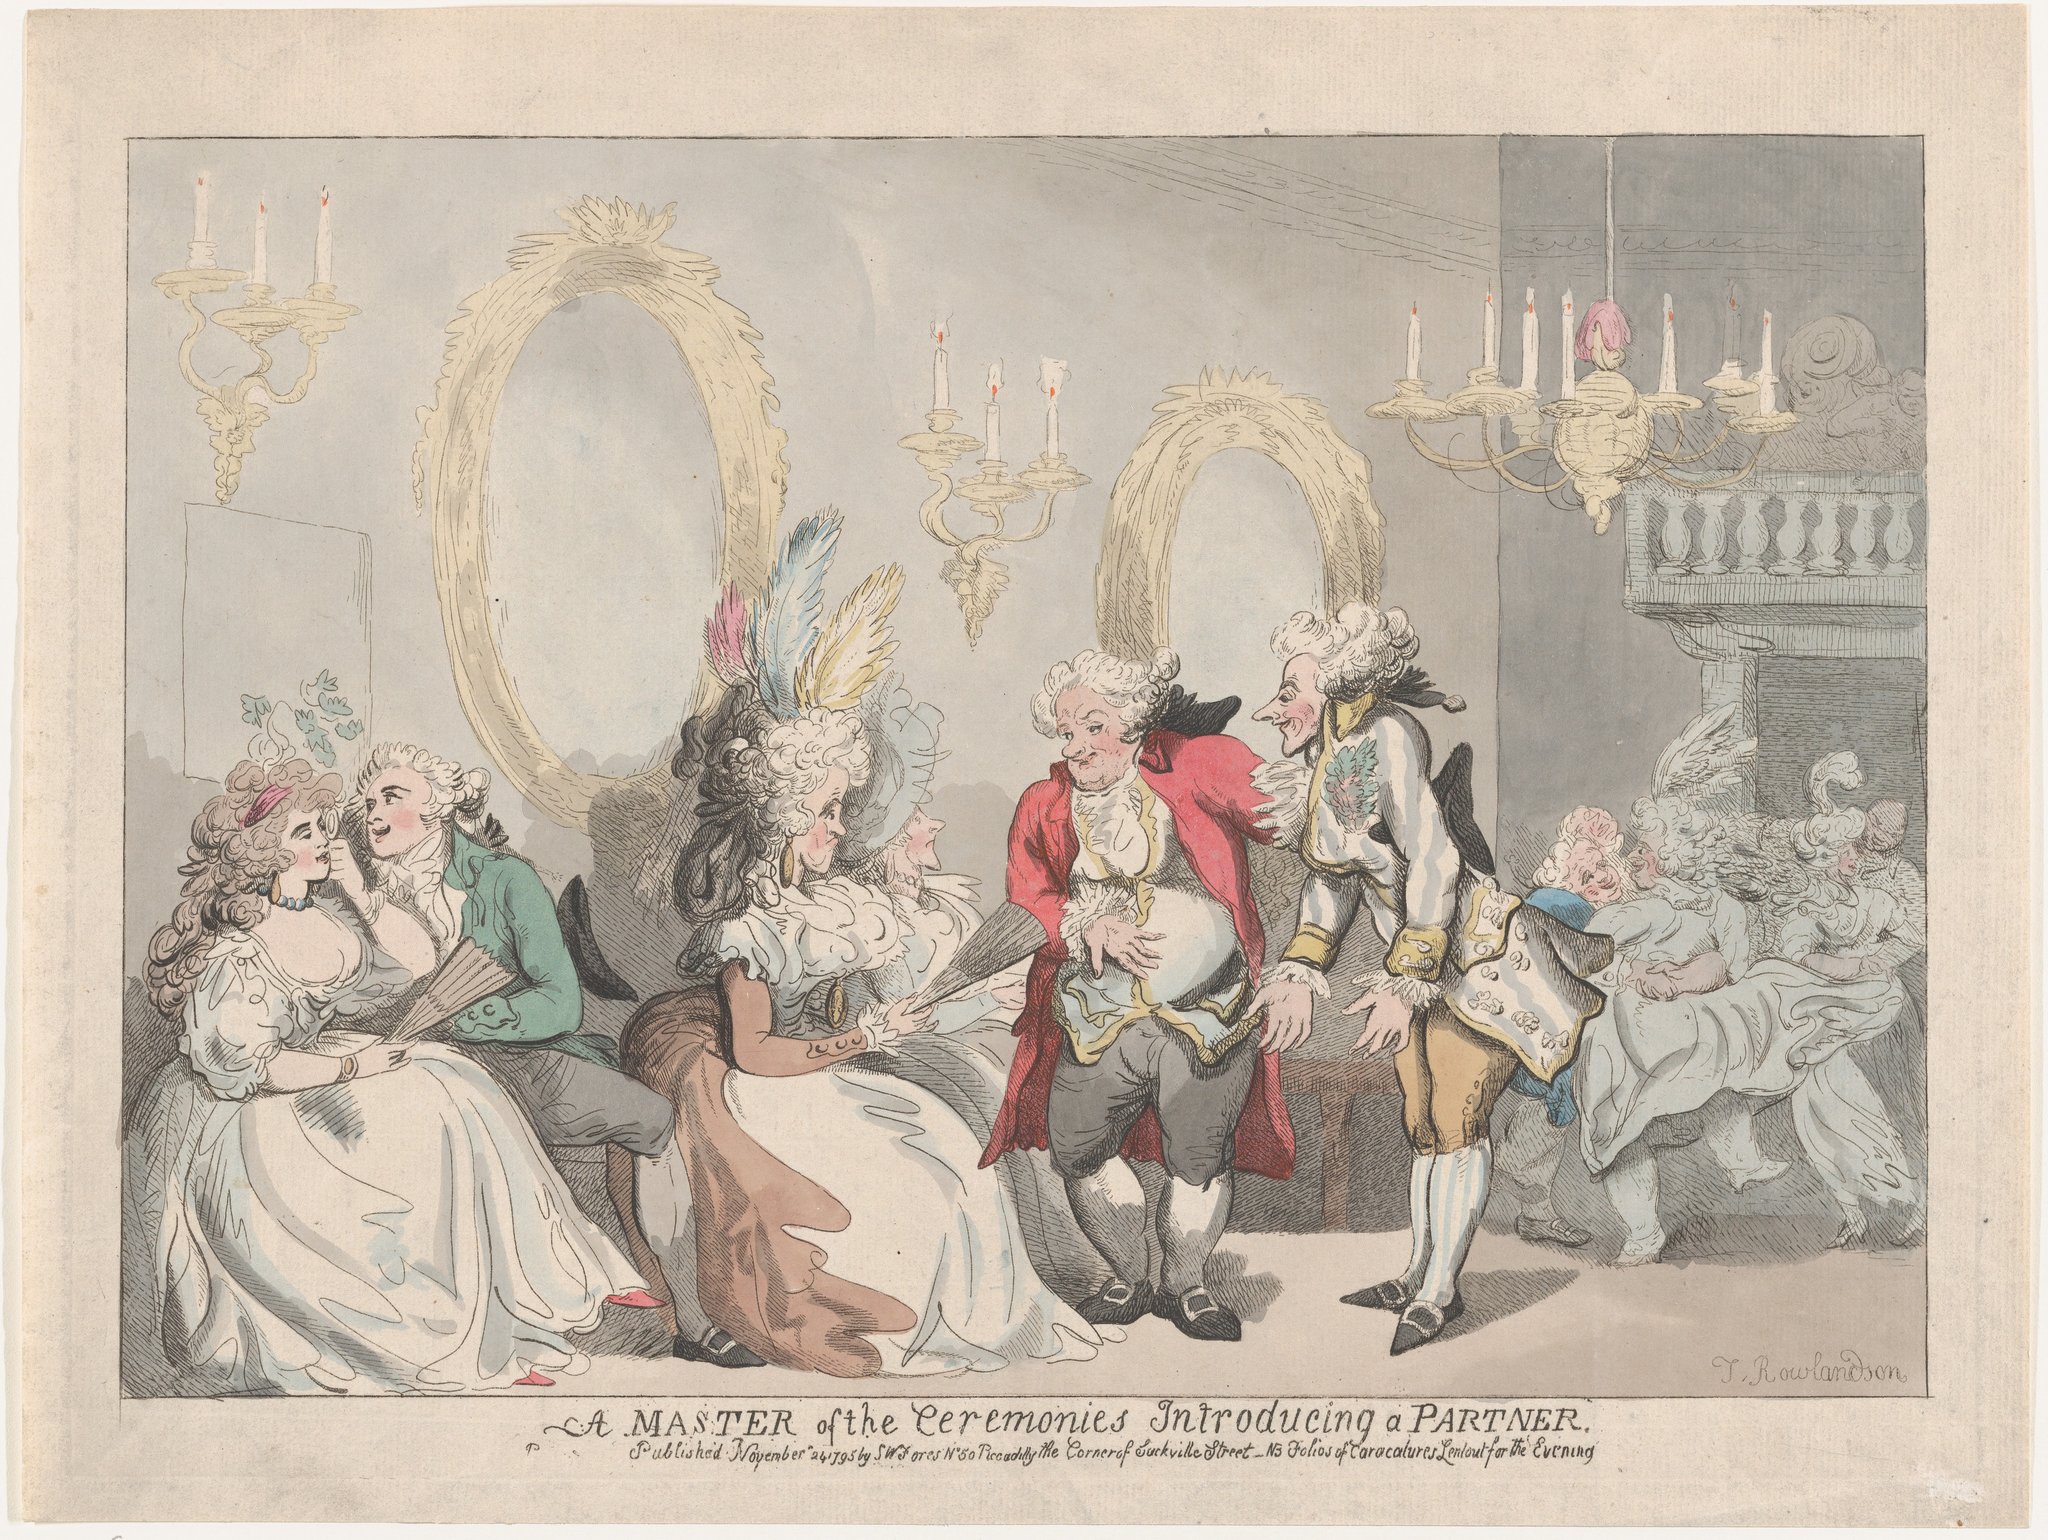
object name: print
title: A Master of the Ceremonies Introducing a Partner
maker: thomas rowlandson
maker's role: artist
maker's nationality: british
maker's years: 1757-1827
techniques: etching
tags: satire,men,women